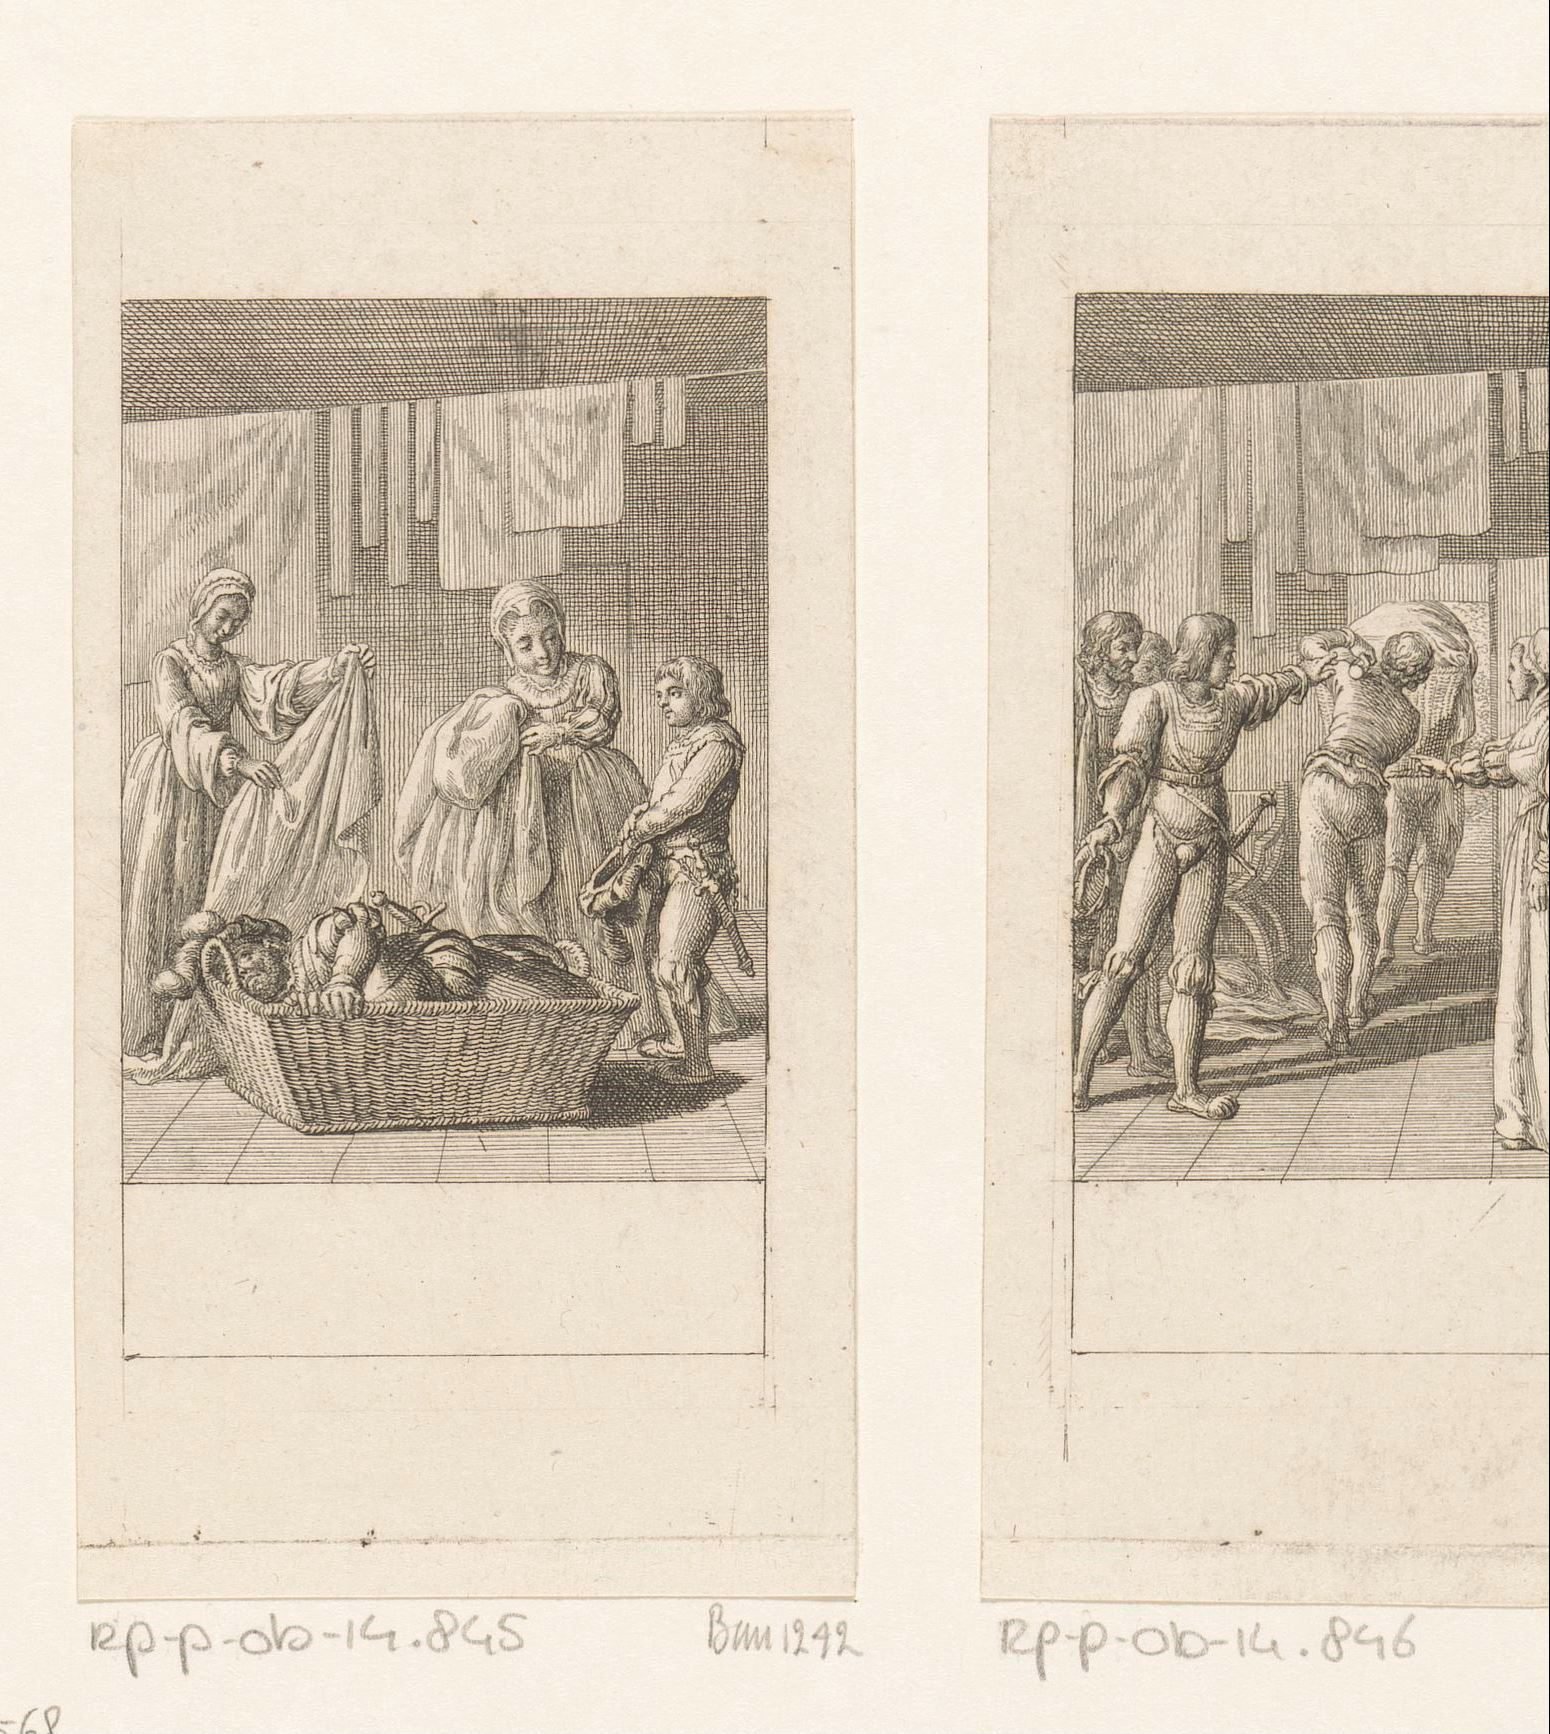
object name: print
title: Falstaff wordt verstopt in de wasmand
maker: daniel nikolaus chodowiecki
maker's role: draughtsman, print maker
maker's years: 1726-1801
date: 1786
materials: paper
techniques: etching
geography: berlin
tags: william shakespeare, laundering, hiding, hiding oneself, falstaff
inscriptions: collector's mark: Lugt 2228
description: Vervaardigd voor William Shakespeares 'The Merry Wives of Windsor'. Latere staat gebruikt voor: Goettinger Taschen Calender vom Jahr 1787. Göttingen: Johann Christoph Dietrich, 1786.